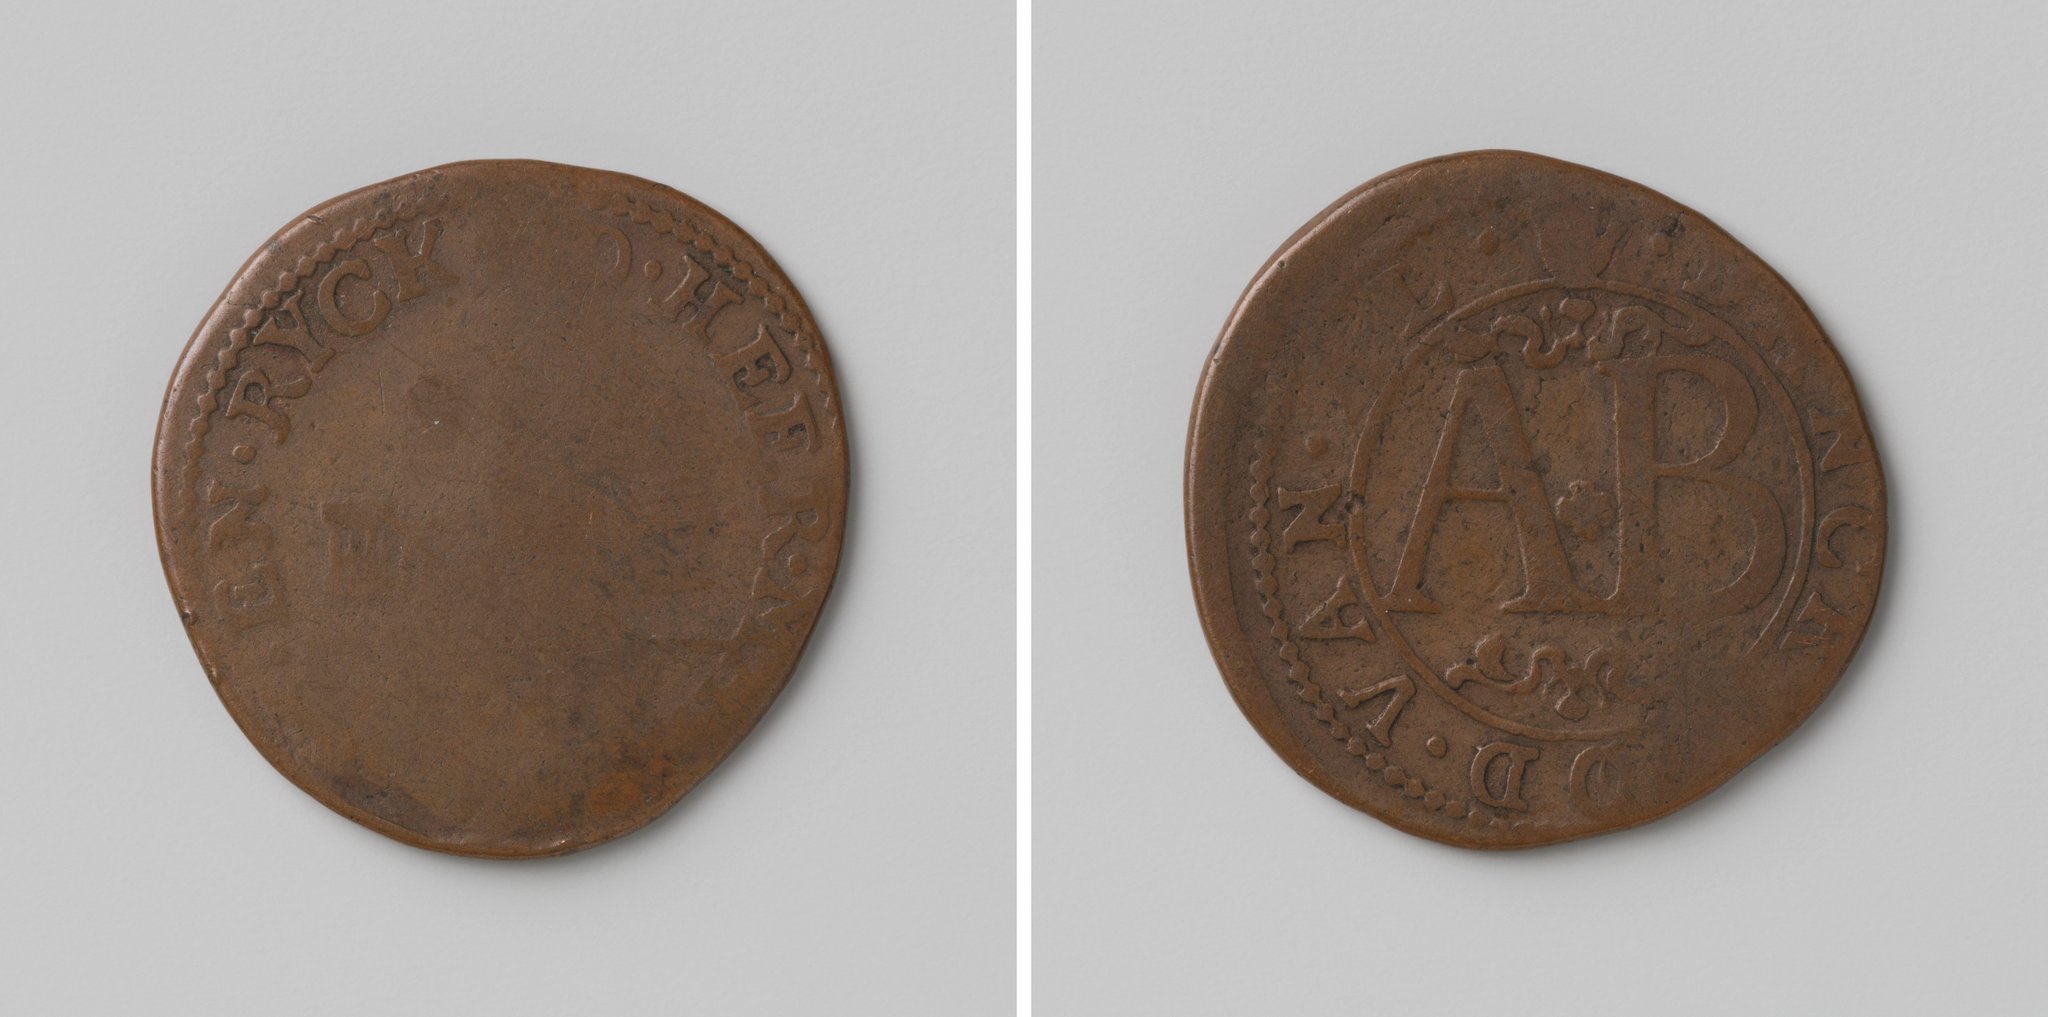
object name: bread token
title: Stad Antwerpen, loodje dat bij uitdeling recht gaf op brood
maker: Anonymous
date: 1677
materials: copper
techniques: striking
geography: antwerp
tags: antwerp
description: Koperen penning. Voorzijde: twee geopende handen boven burcht en jaartal binnen omschrift. Keerzijde: monogram van letters A en B tussen ornament binnen omschrift